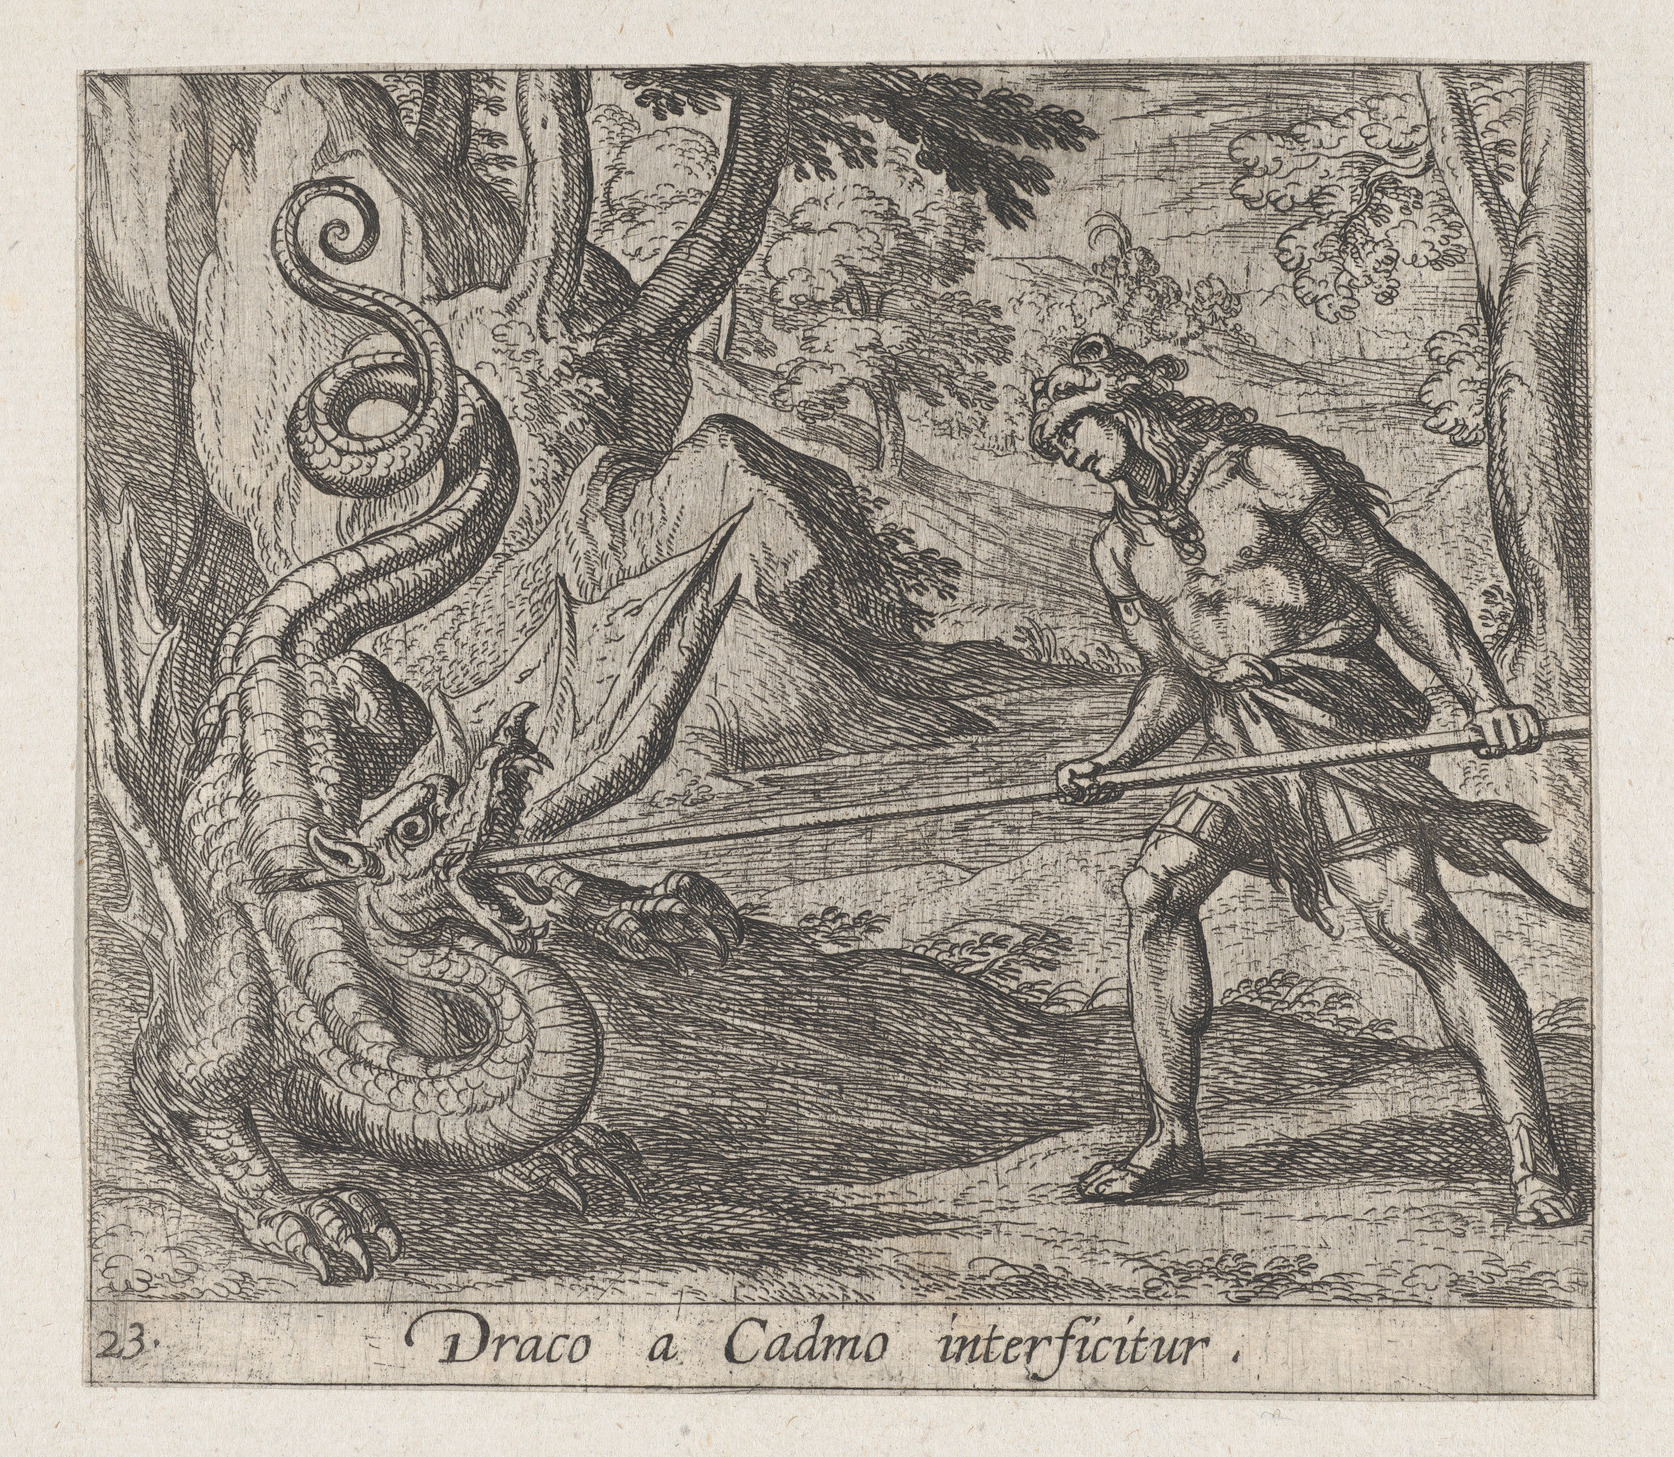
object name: print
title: Plate 23: Cadmus Killing the Serpent (Draco a Cadmo interficitur), from Ovid's 'Metamorphoses'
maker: antonio tempesta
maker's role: artist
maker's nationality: italian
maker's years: 1555-1630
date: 1606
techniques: etching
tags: men,serpents